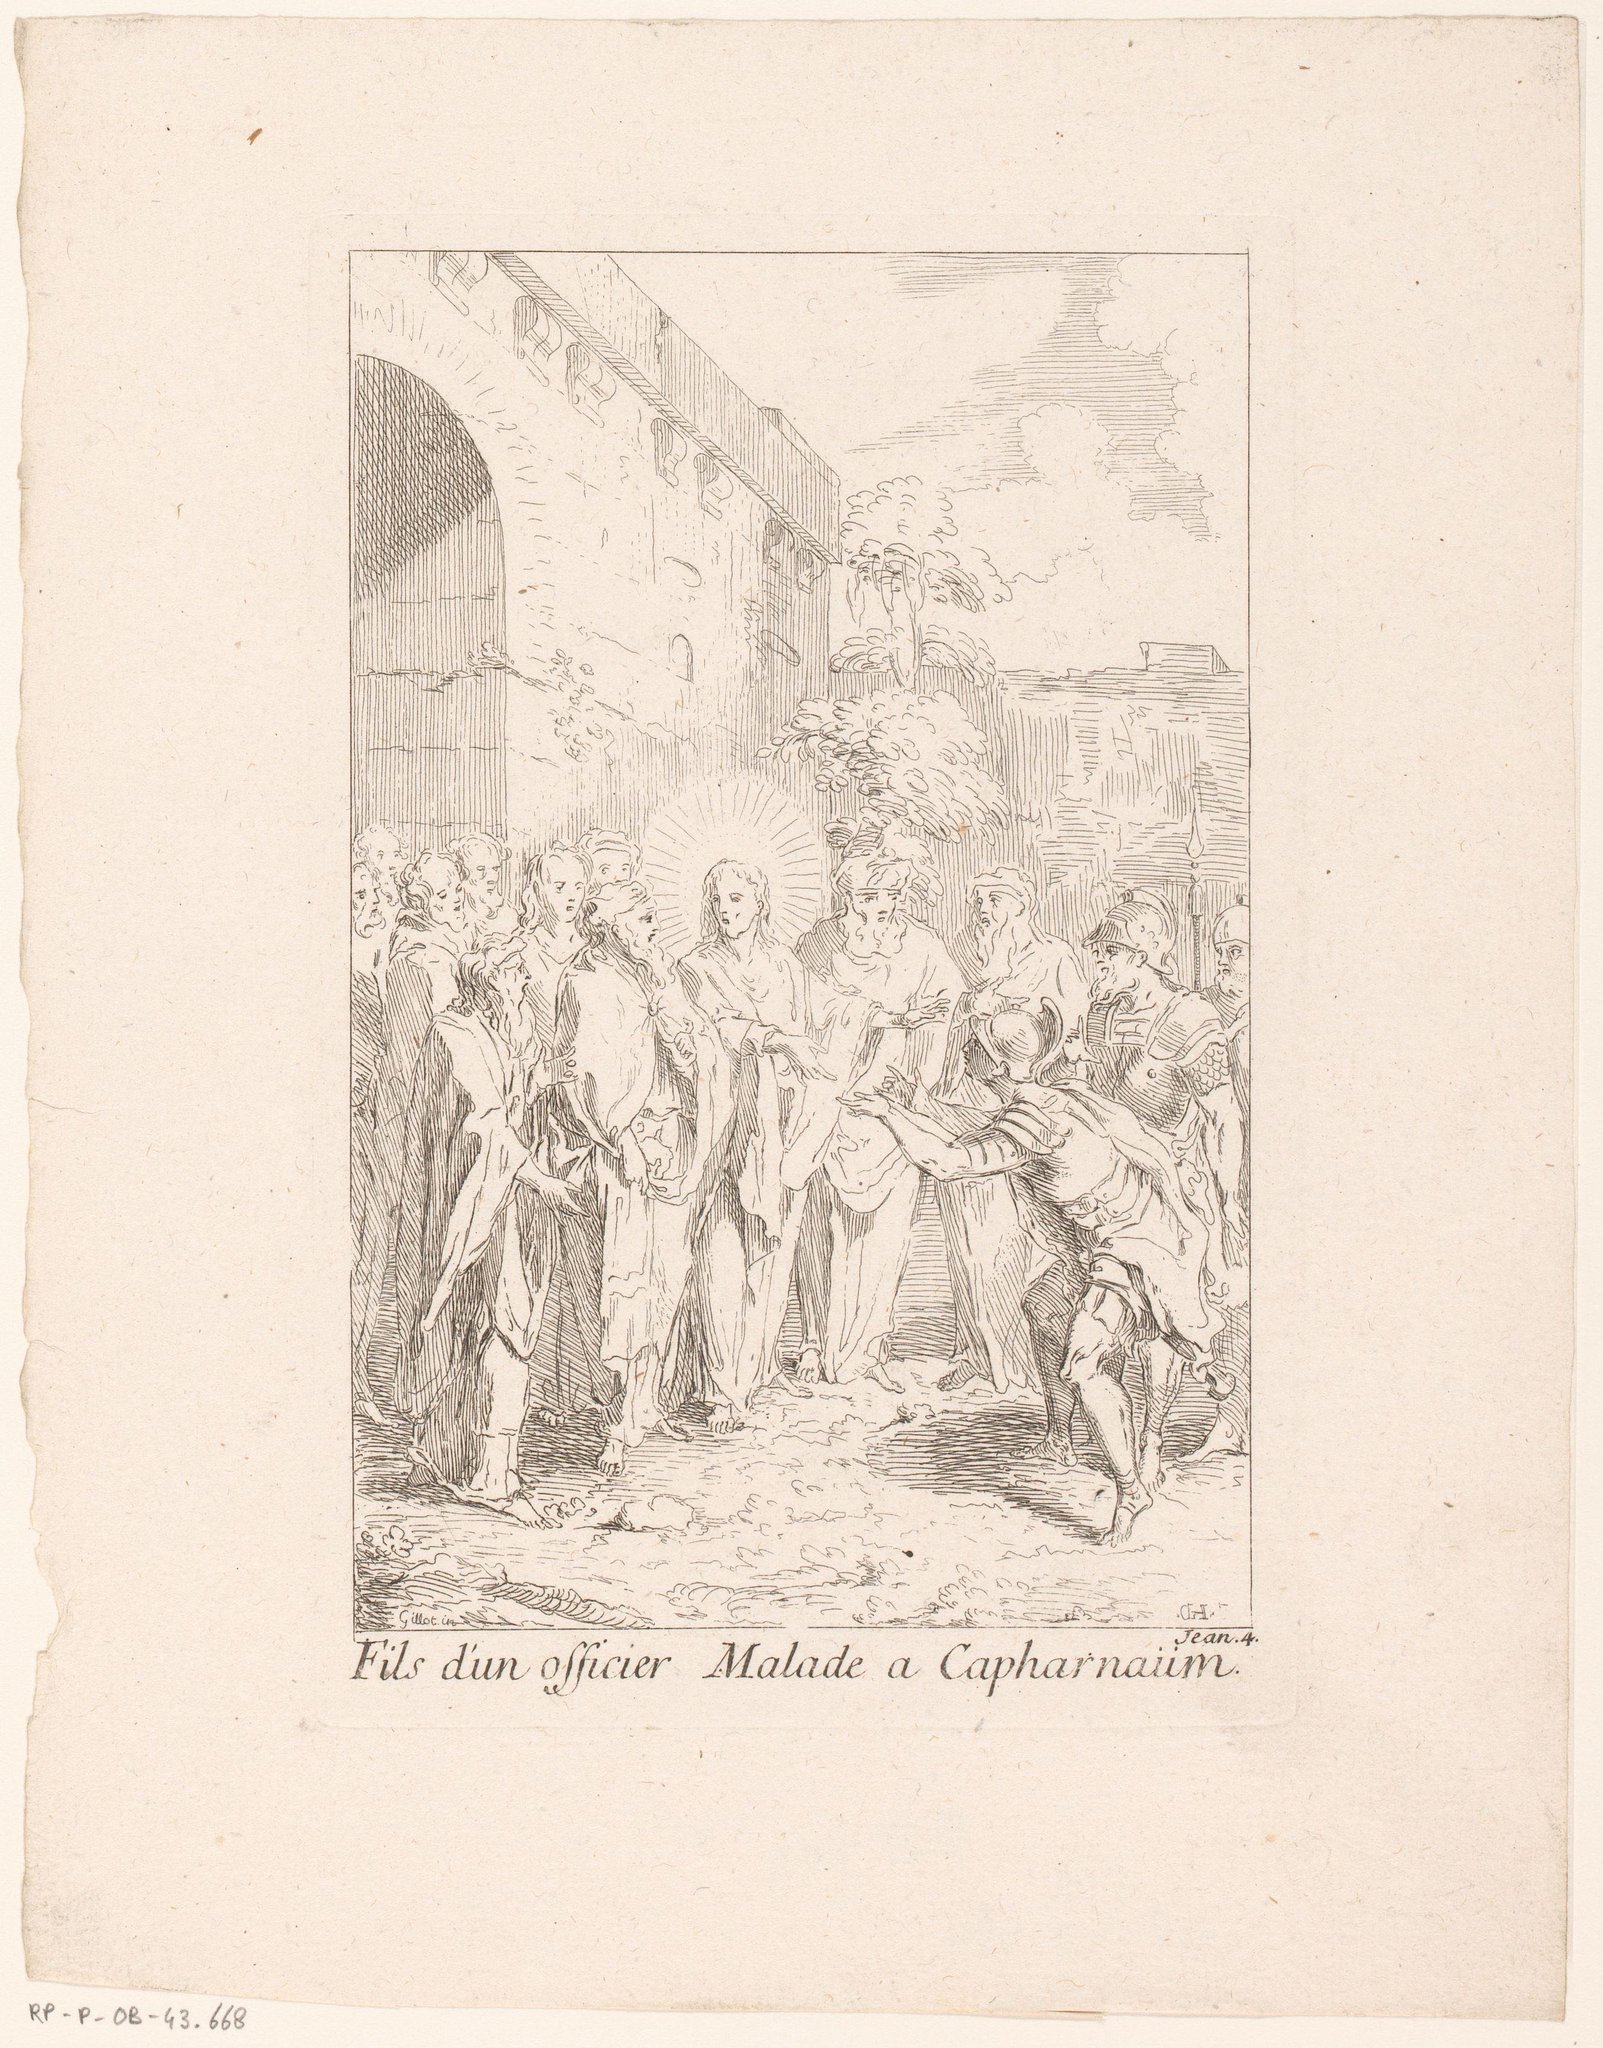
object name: print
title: Fils d'un officier Malade a Capharnaüm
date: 1705-1732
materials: paper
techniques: etching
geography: france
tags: the centurion of capernaum, kneeling before christ, begs him to heal his paralytic servant (or son) (matthew 8:5-13; luke 7:1-10; john 4:46-54)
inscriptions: collector's mark: Lugt 2228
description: Maakt deel uit van een serie met zestig prenten met als thema het leven van Christus.